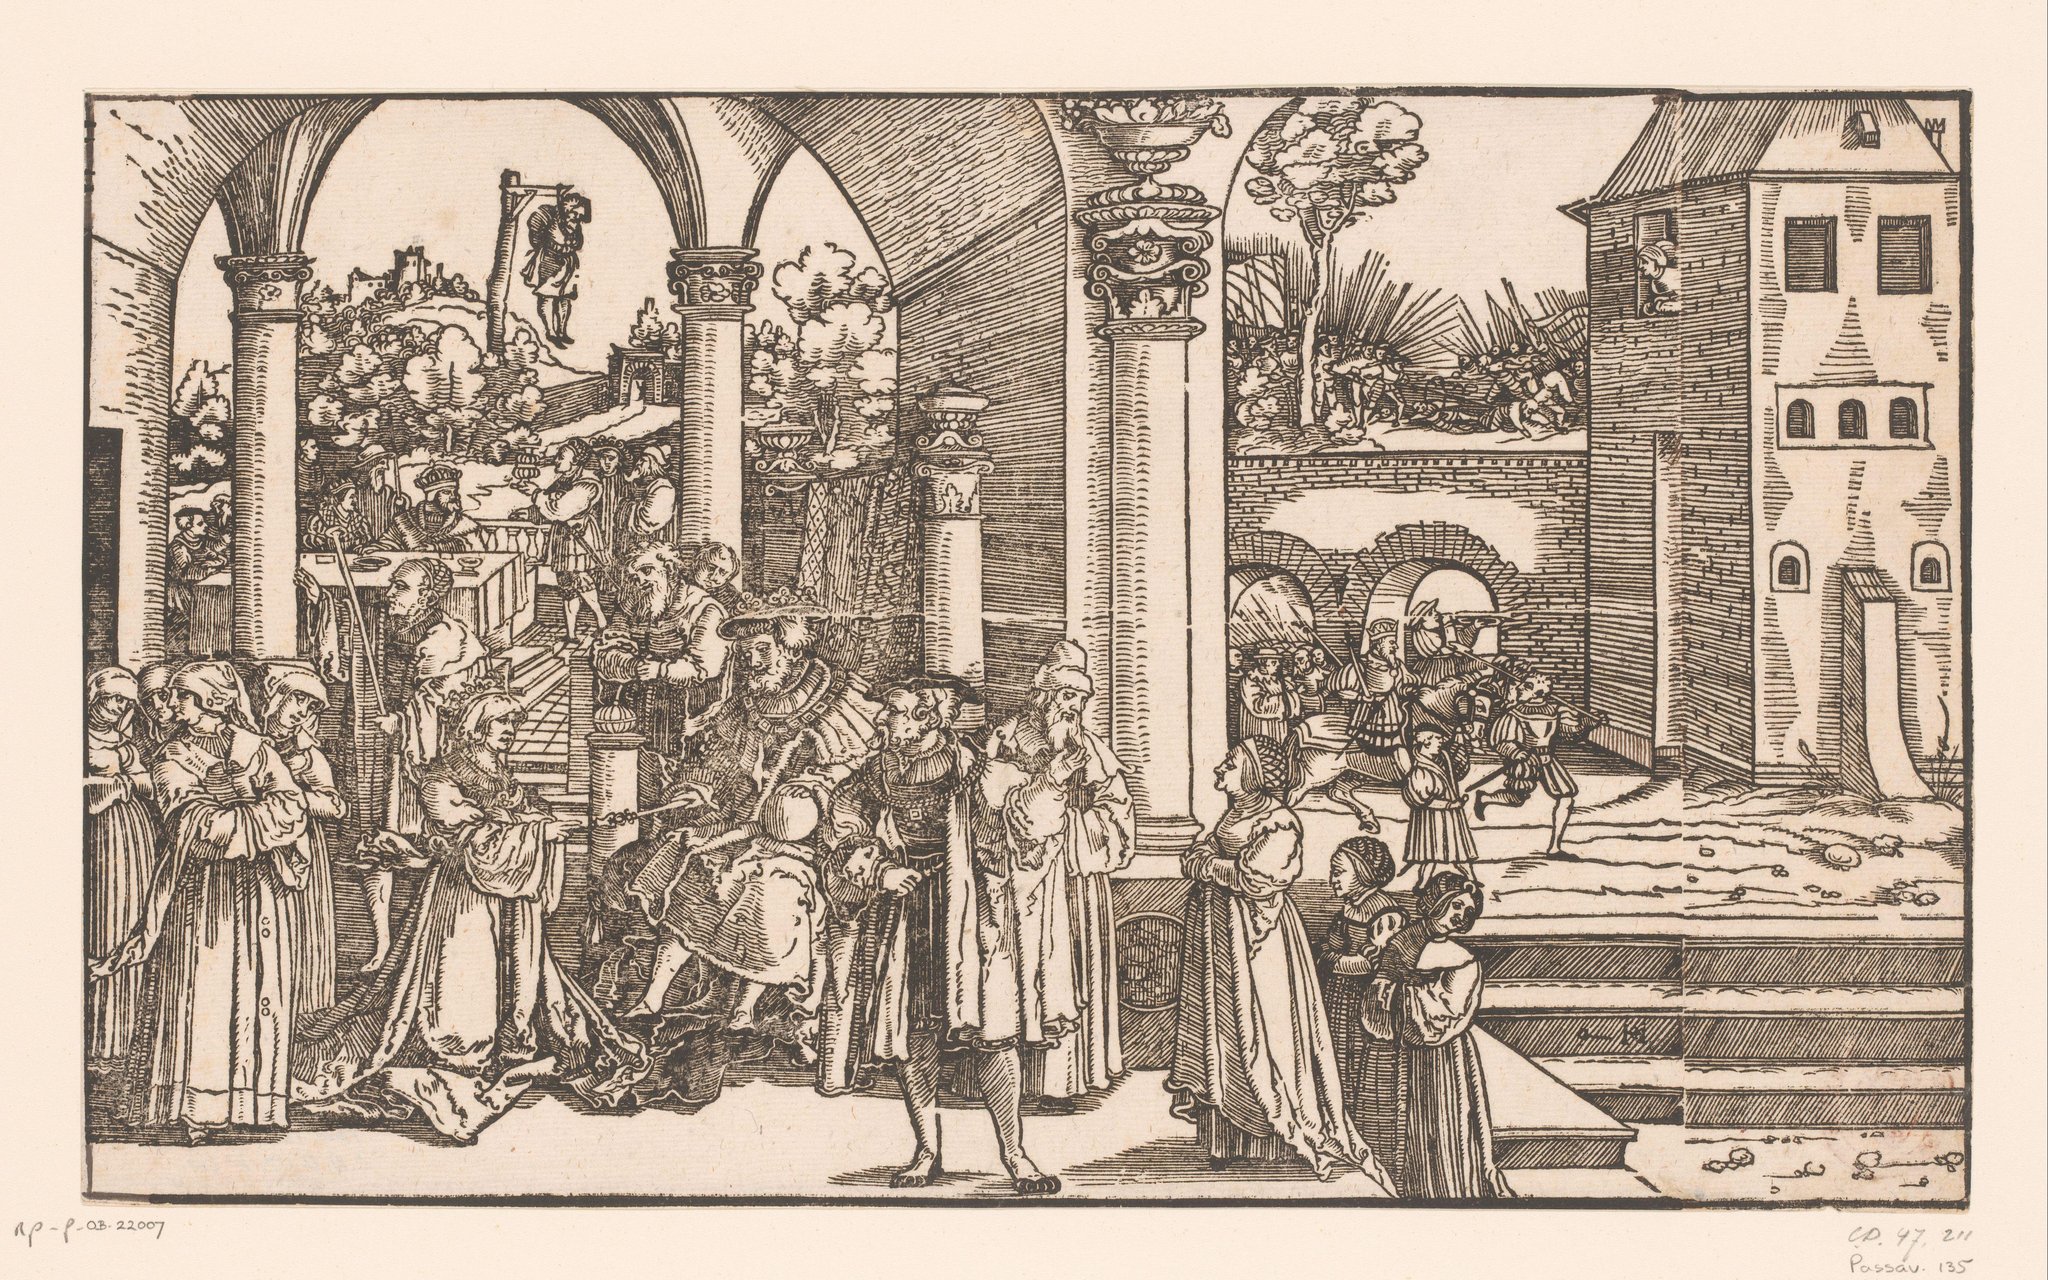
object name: print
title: Verhaal van Ester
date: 1533-1539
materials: paper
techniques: woodcut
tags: the story of esther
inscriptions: collector's mark: Lugt 240